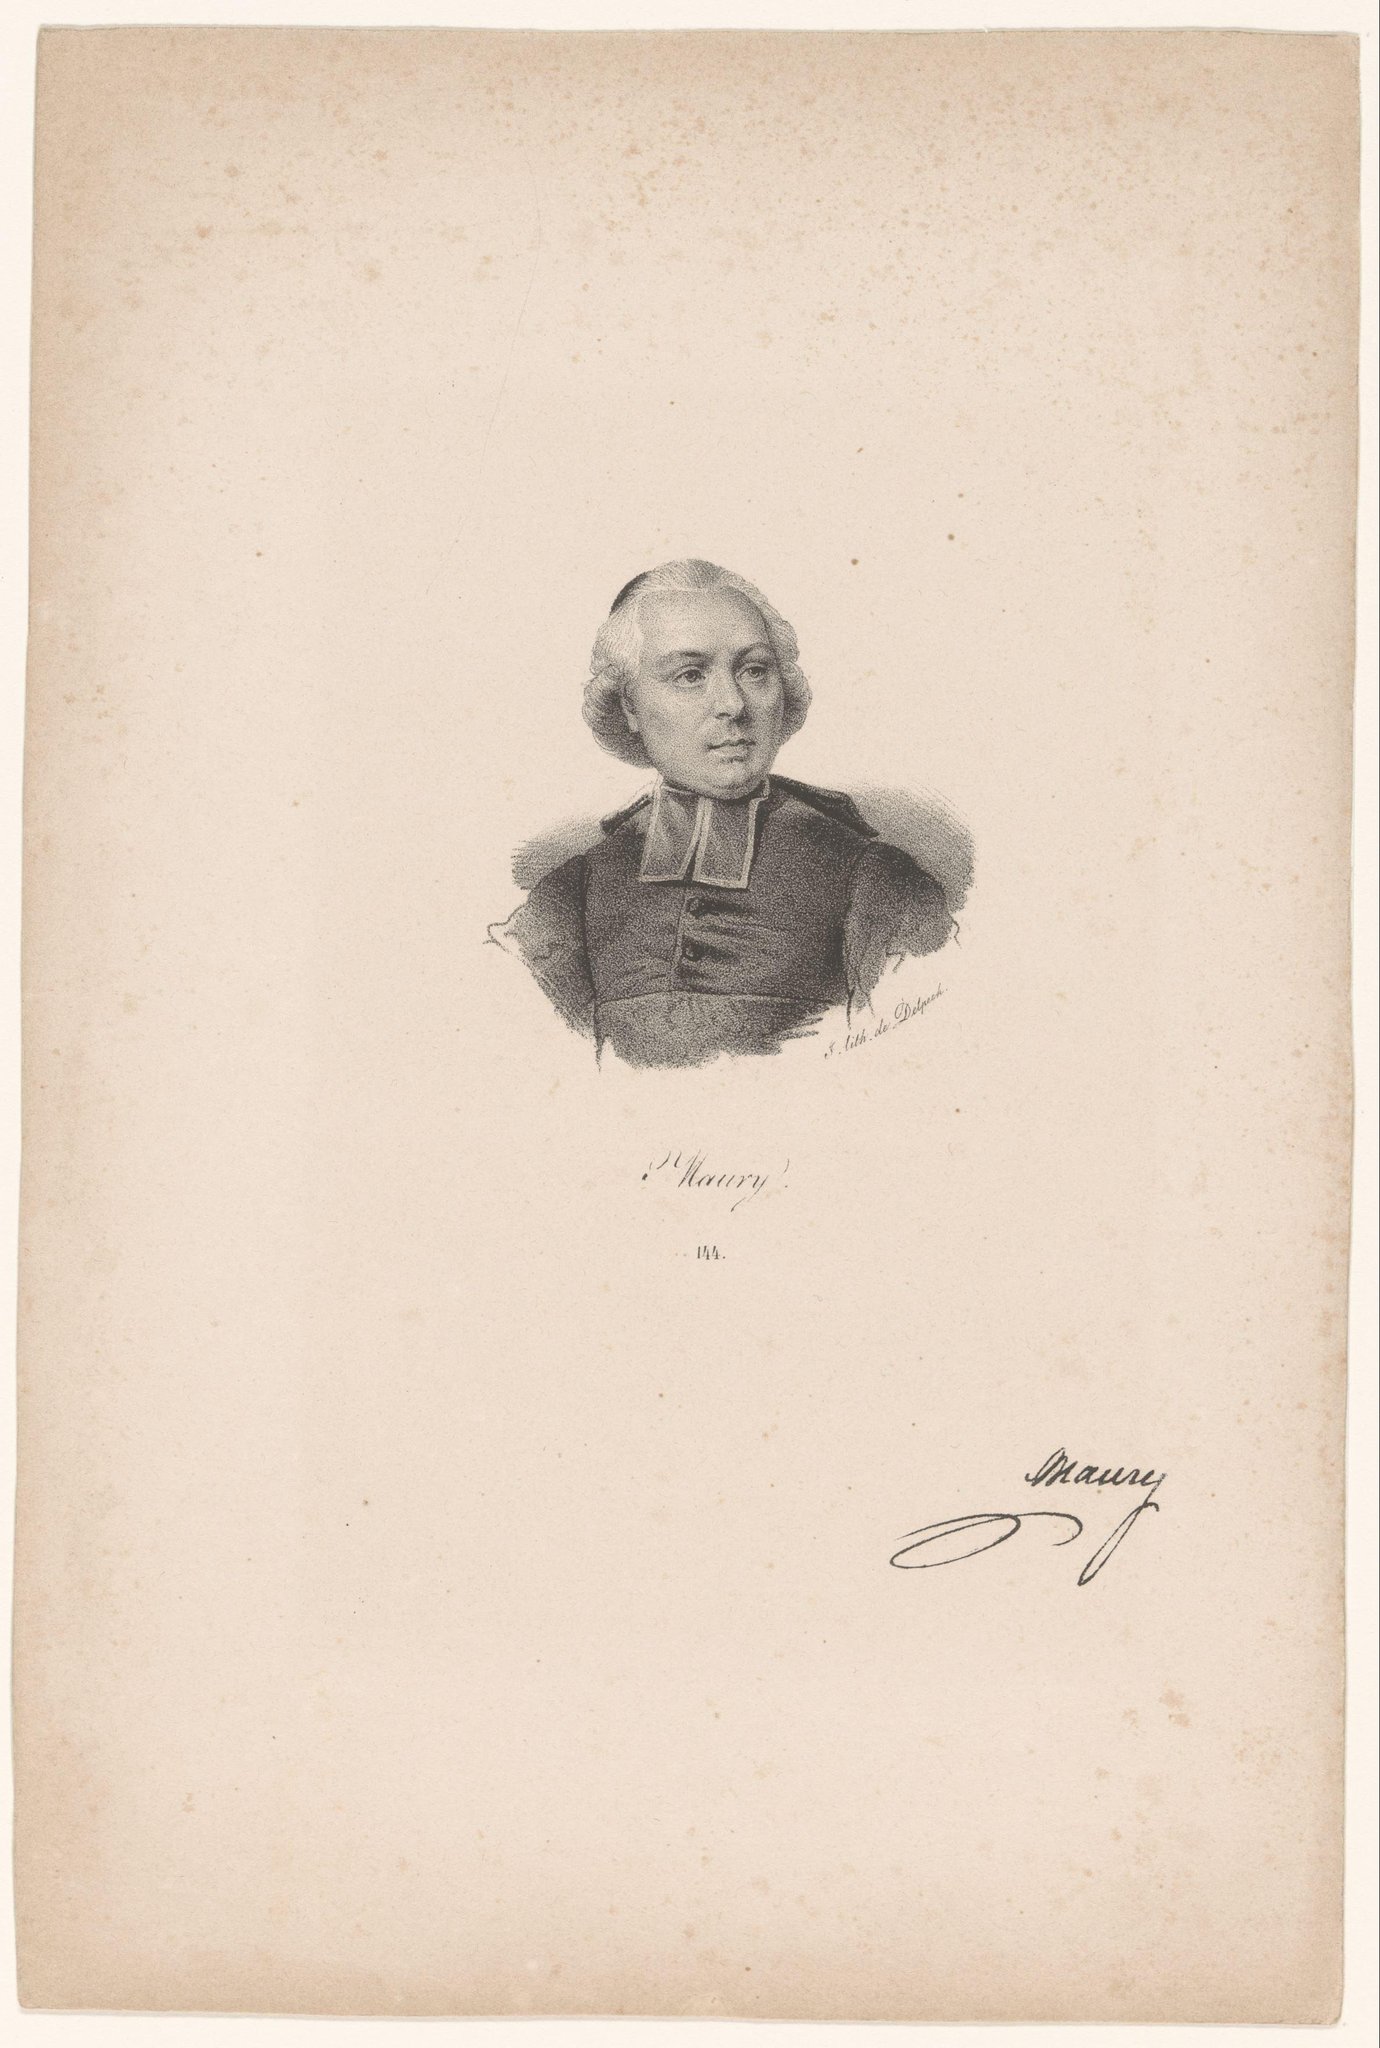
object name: print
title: Portret van Jean-Sifrein Maury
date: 1818-1842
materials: paper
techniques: lithograph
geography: paris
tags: historical persons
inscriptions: collector's mark: Lugt 2228a